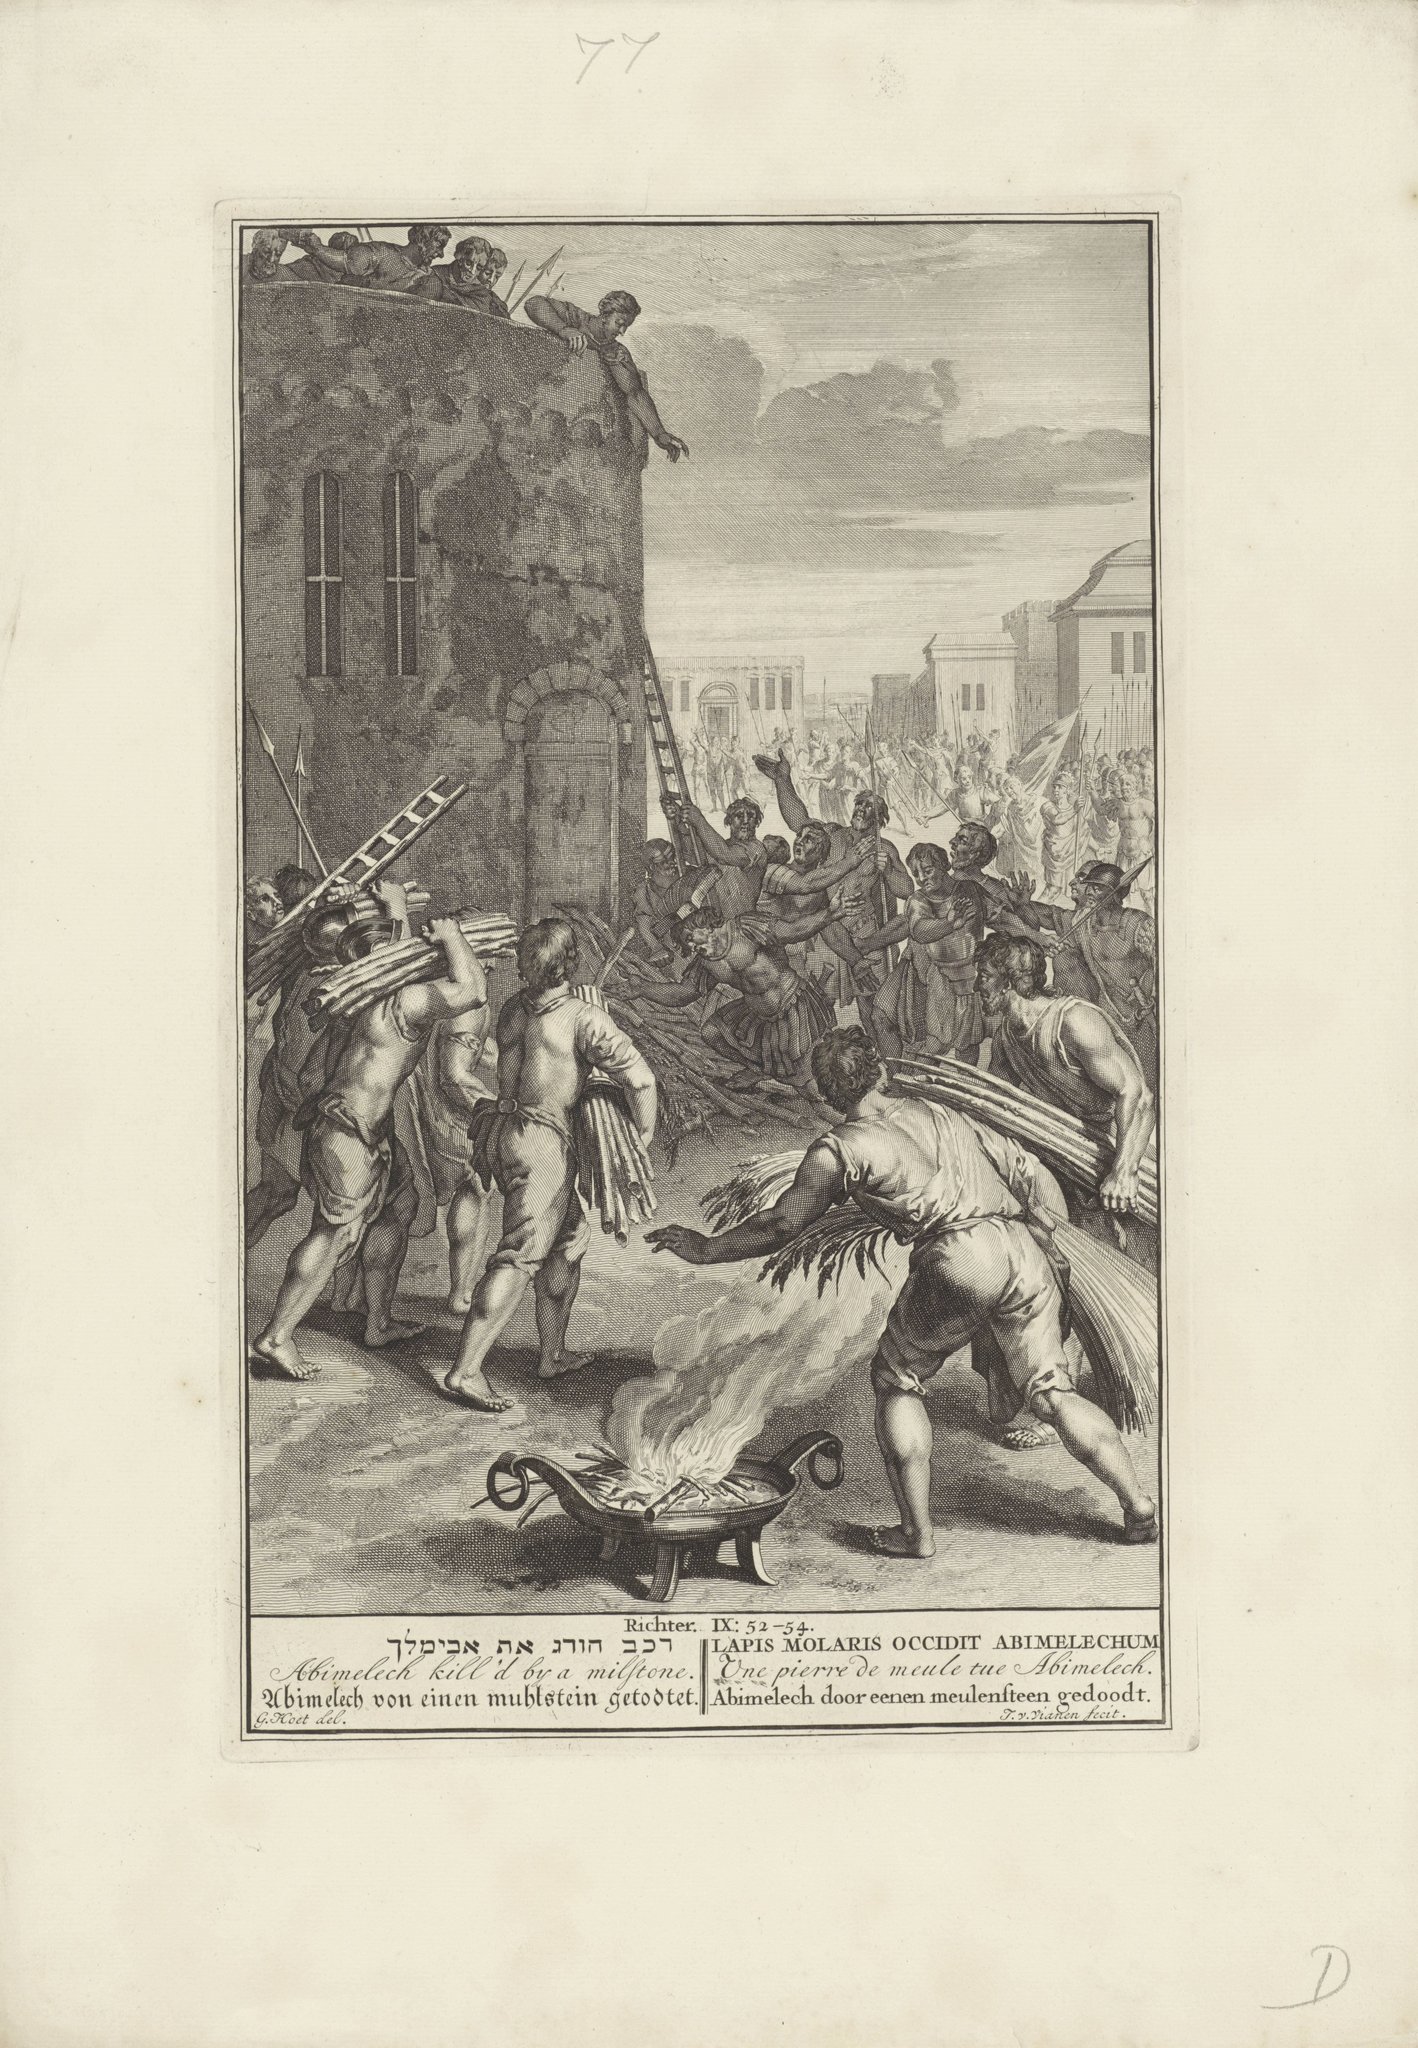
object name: print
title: Abimelech door een molensteen gedood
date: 1705-1720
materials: paper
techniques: engraving, etching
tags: abimelech is struck on the head by a millstone thrown by a woman, god calls adam and eve to account for their deed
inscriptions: collector's mark: Lugt 2228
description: Prent oorspronkelijk bedoeld voor: Figures de la Bible. Amsterdam: Bernard Picart, 1720. Prent ook gebruikt in: Taferelen der voornaamste geschiedenissen van het Oude en Nieuwe Testament (...) door de vermaarde kunstenaars Hoet, Houbraken, en Picart getekent (...) en met beschrijvingen uitgebreid. Den Haag: Pieter de Hondt, 1728.